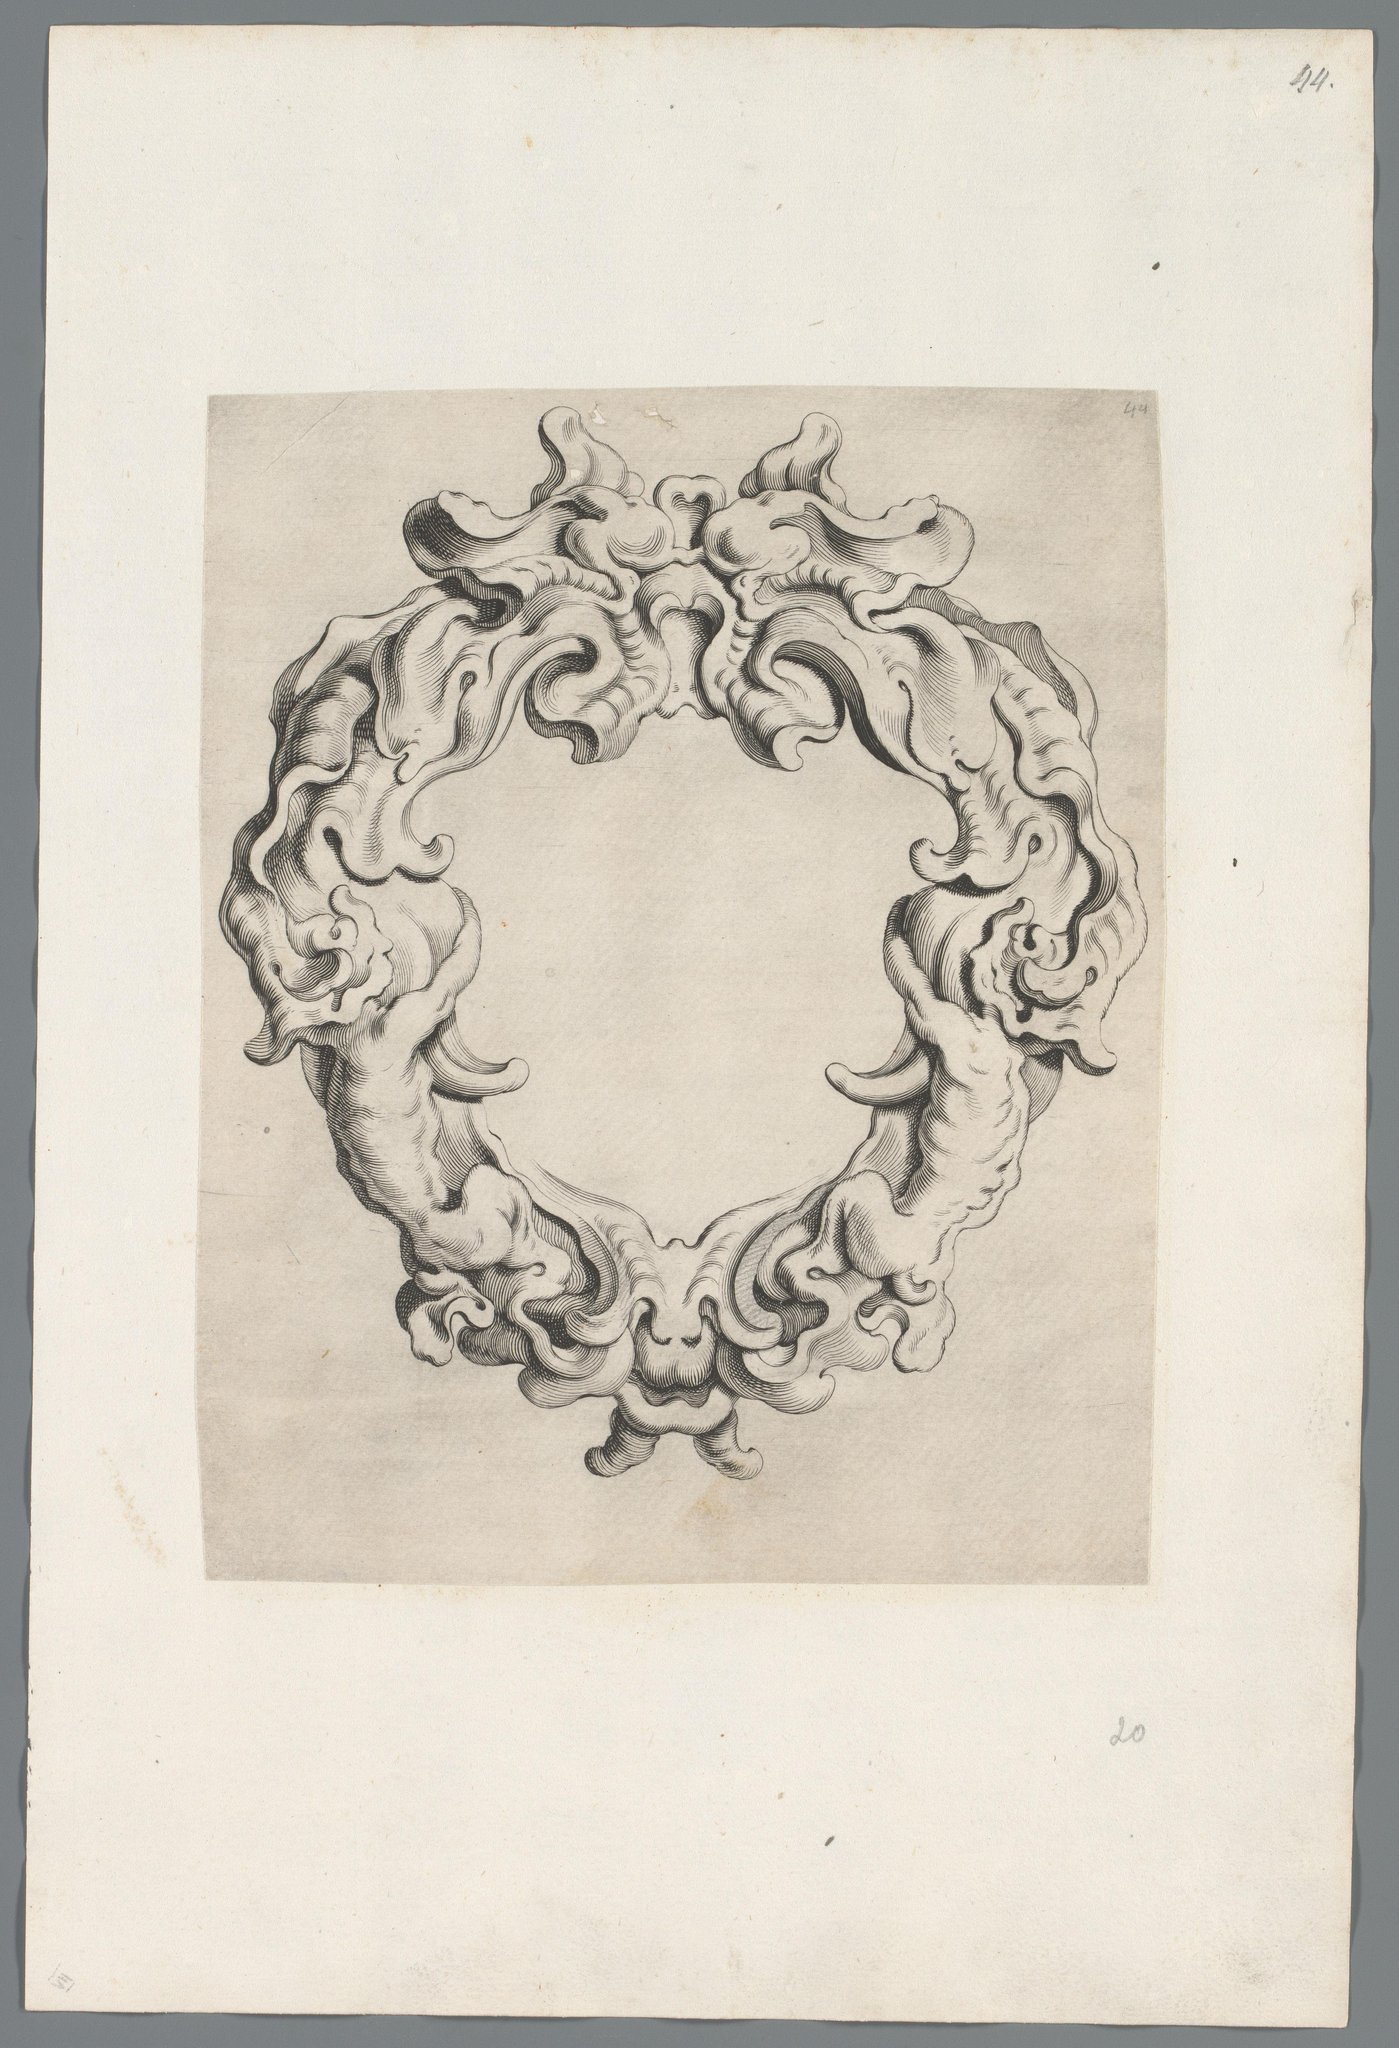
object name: ornament print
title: Cartouche in kwabstijl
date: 1640-1674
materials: paper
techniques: engraving, etching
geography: amsterdam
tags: auricular ornament, lobe style ~ ornament, ornament ~ cartouche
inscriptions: collector's mark: Lugt 2760, collector's mark: Lugt 2228